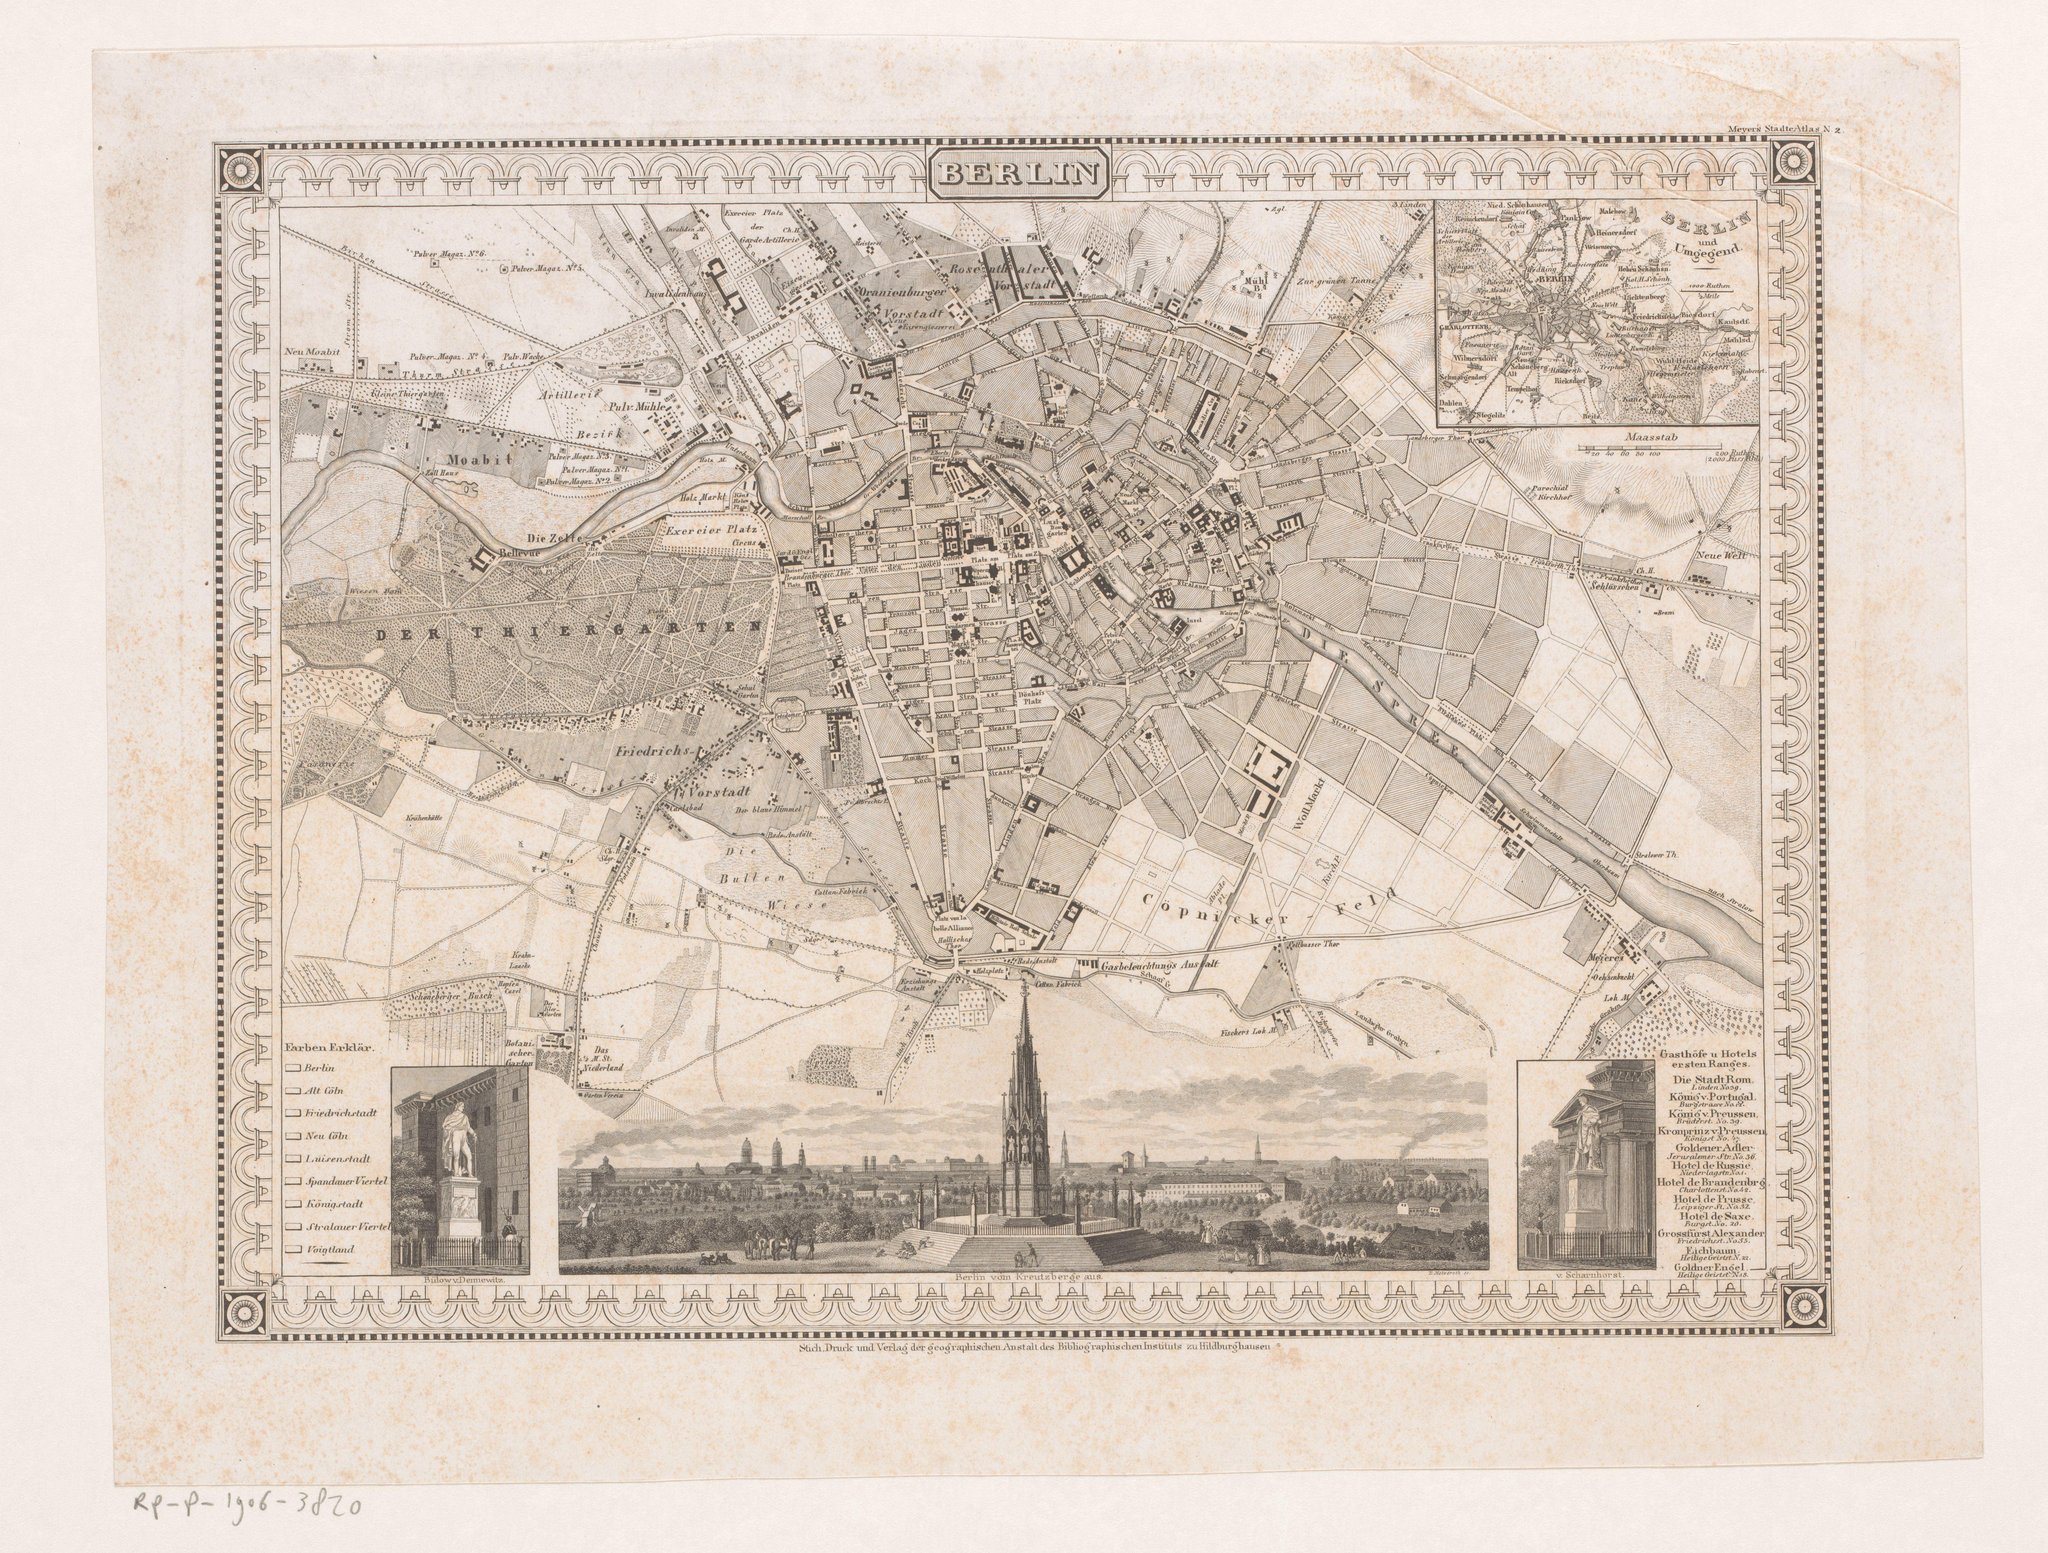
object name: print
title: Berlin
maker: b. metzeroth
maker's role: print maker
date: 1826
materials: paper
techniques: etching, engraving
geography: hildburghausen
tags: maps of cities, berlin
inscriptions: collector's mark: Lugt 2228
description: Illustratie uit: Meyer, Carl Joseph. Meyers Handatlas. Hildburghause: Bibliographischen Institut, 1826.